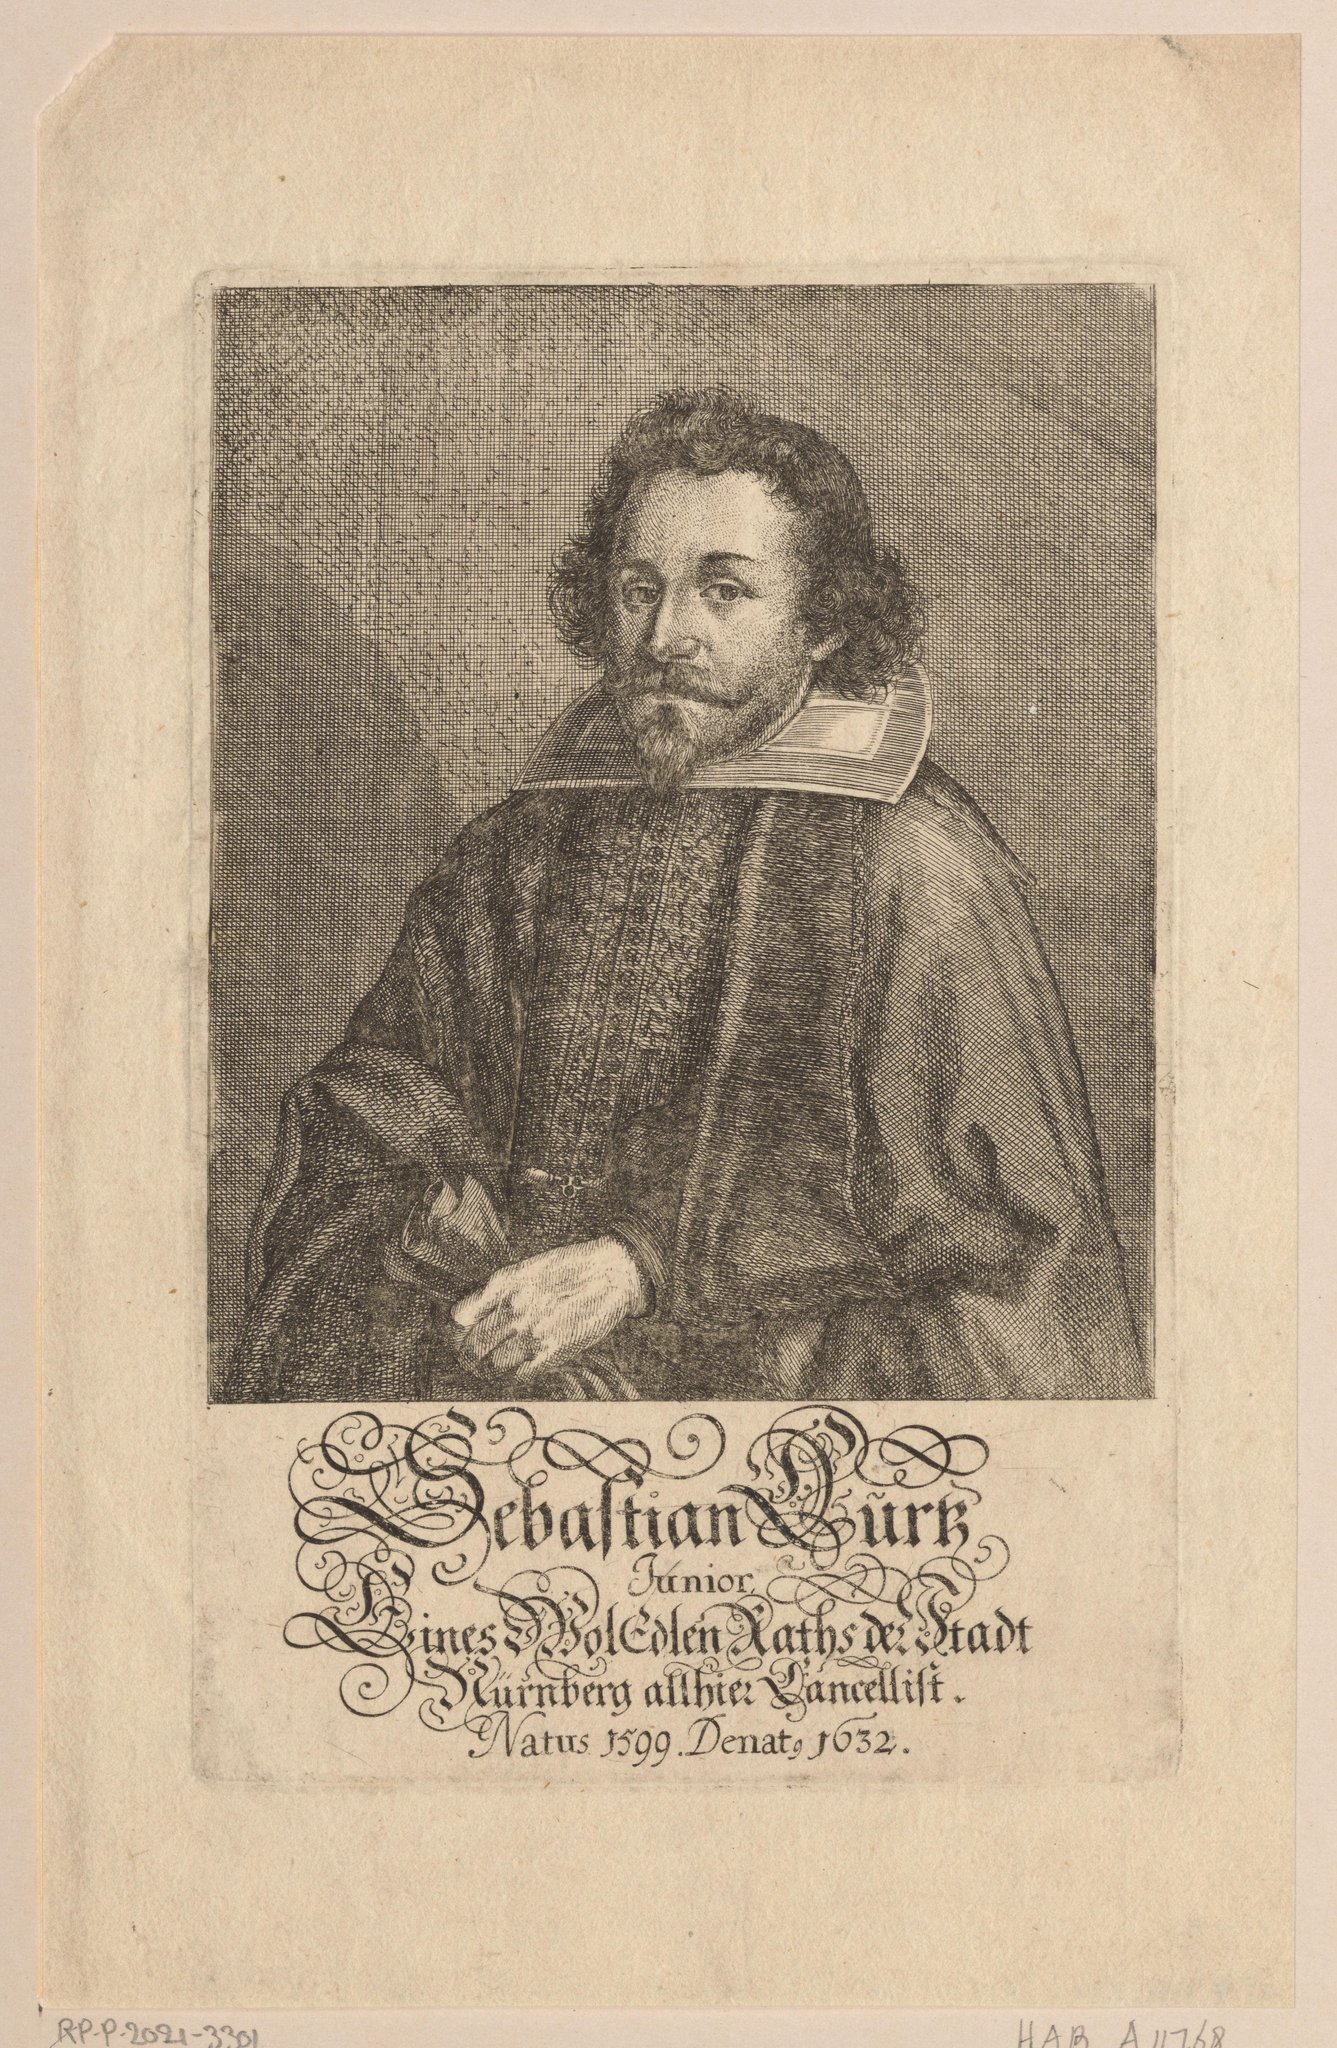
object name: print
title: Portret van Sebastian Kurz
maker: Anonymous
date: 1632-1699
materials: paper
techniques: engraving, etching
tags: historical persons